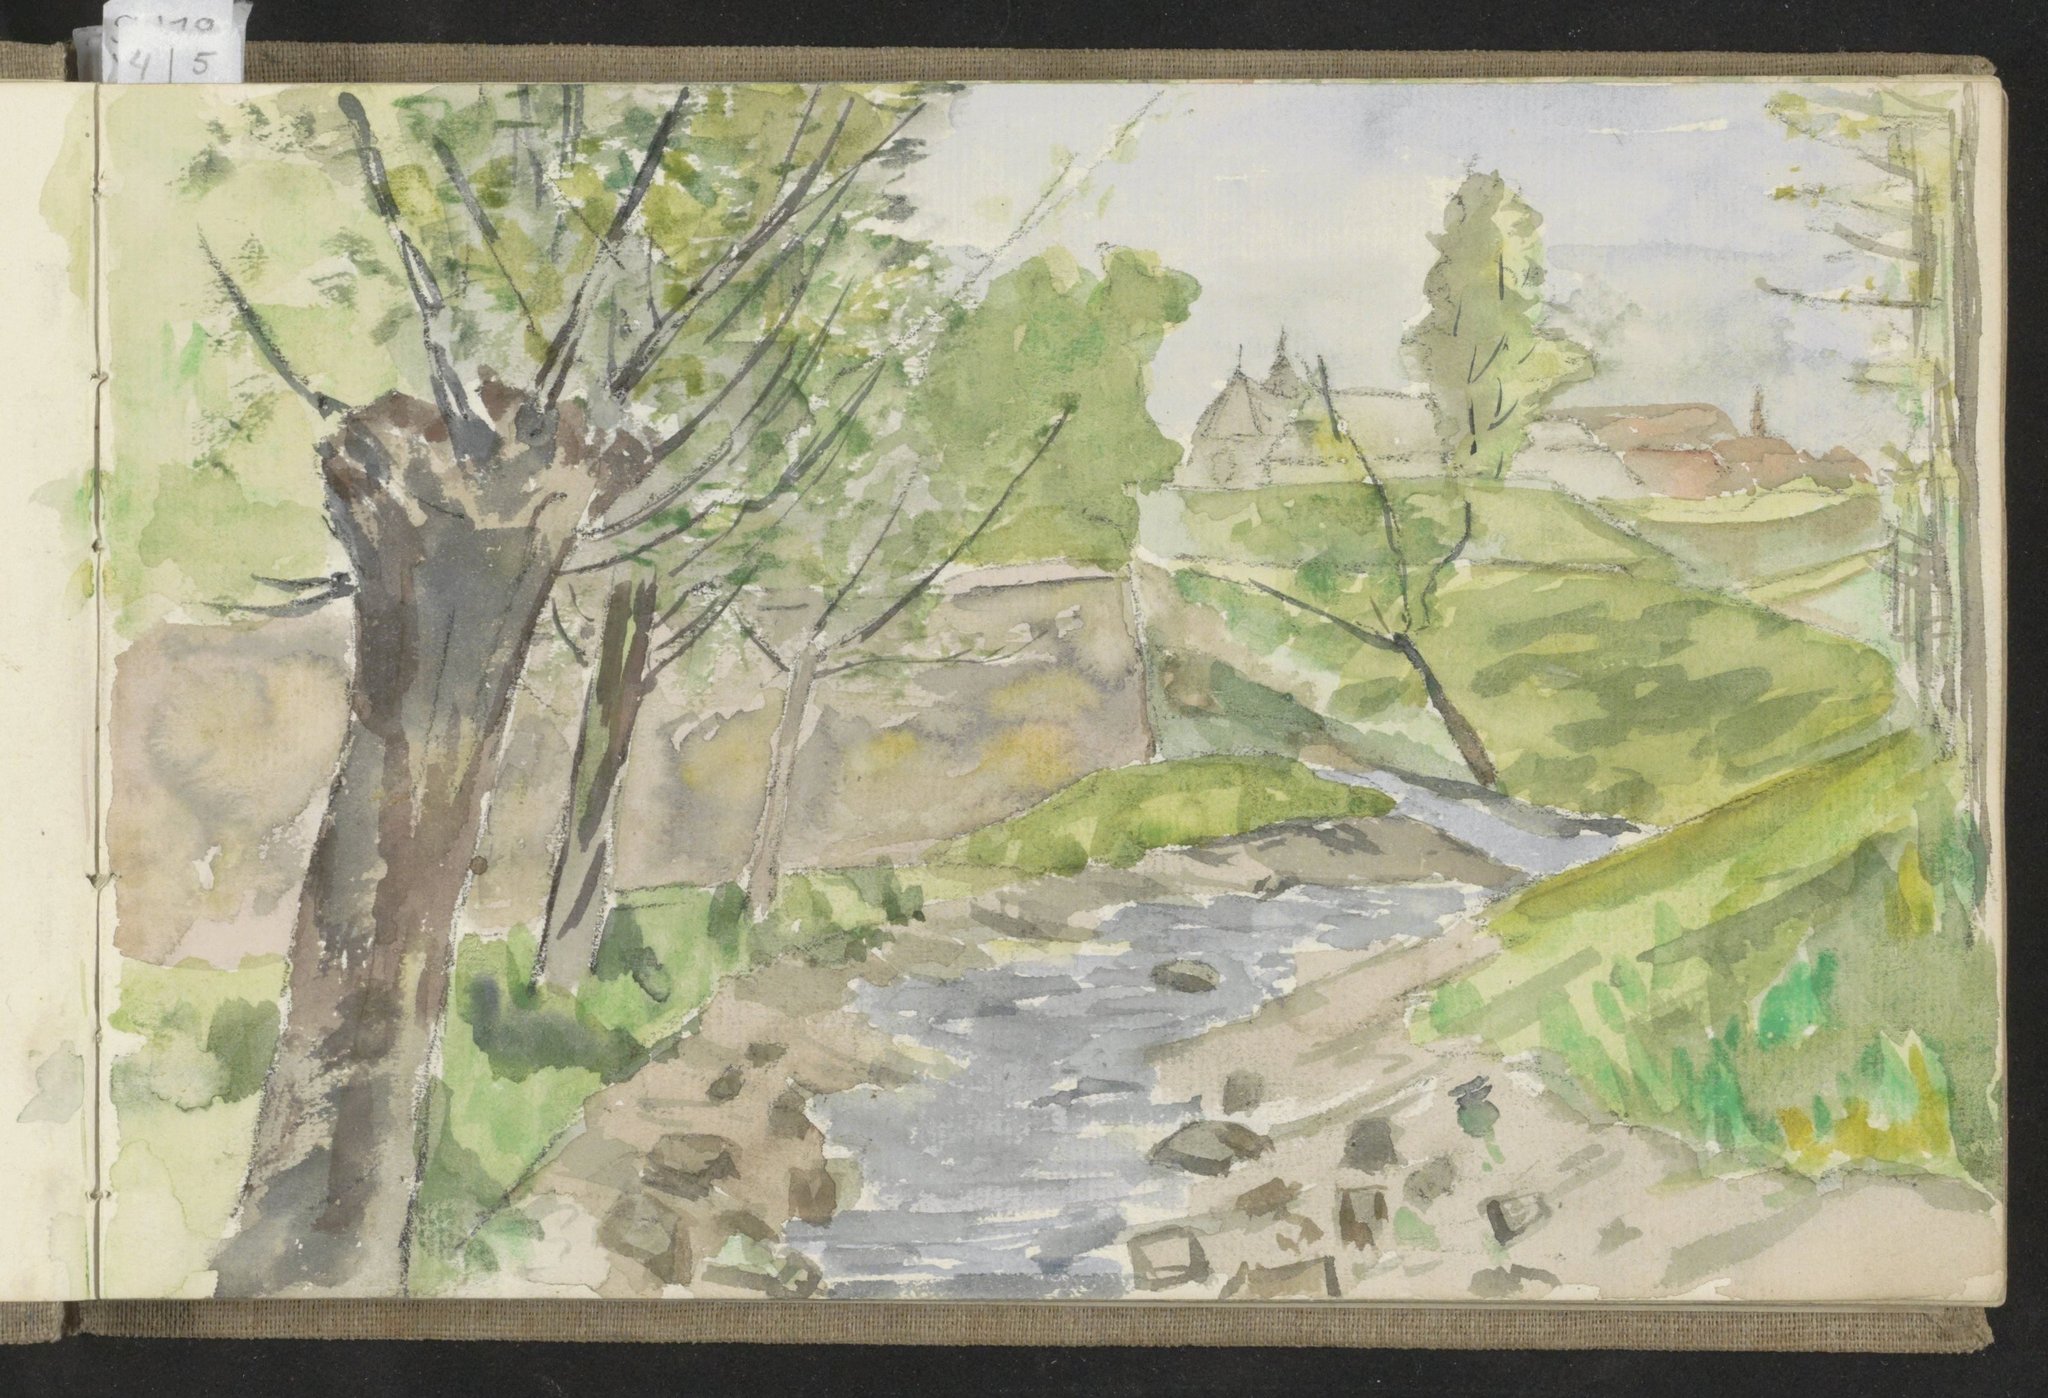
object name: sketchbook leaf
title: Heuvellandschap met een beek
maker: jonkheer johannes ludovicus paulus bosch van drakestein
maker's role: draughtsman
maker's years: 1865-1929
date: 1896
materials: paper, pencil, watercolor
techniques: brush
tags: prospect of village, silhouette of village, landscapes with waters, waterscapes, seascapes (in the temperate zone)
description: Op de achtergrond een dorp. Blad 3 recto uit een schetsboek met 58 bladen.